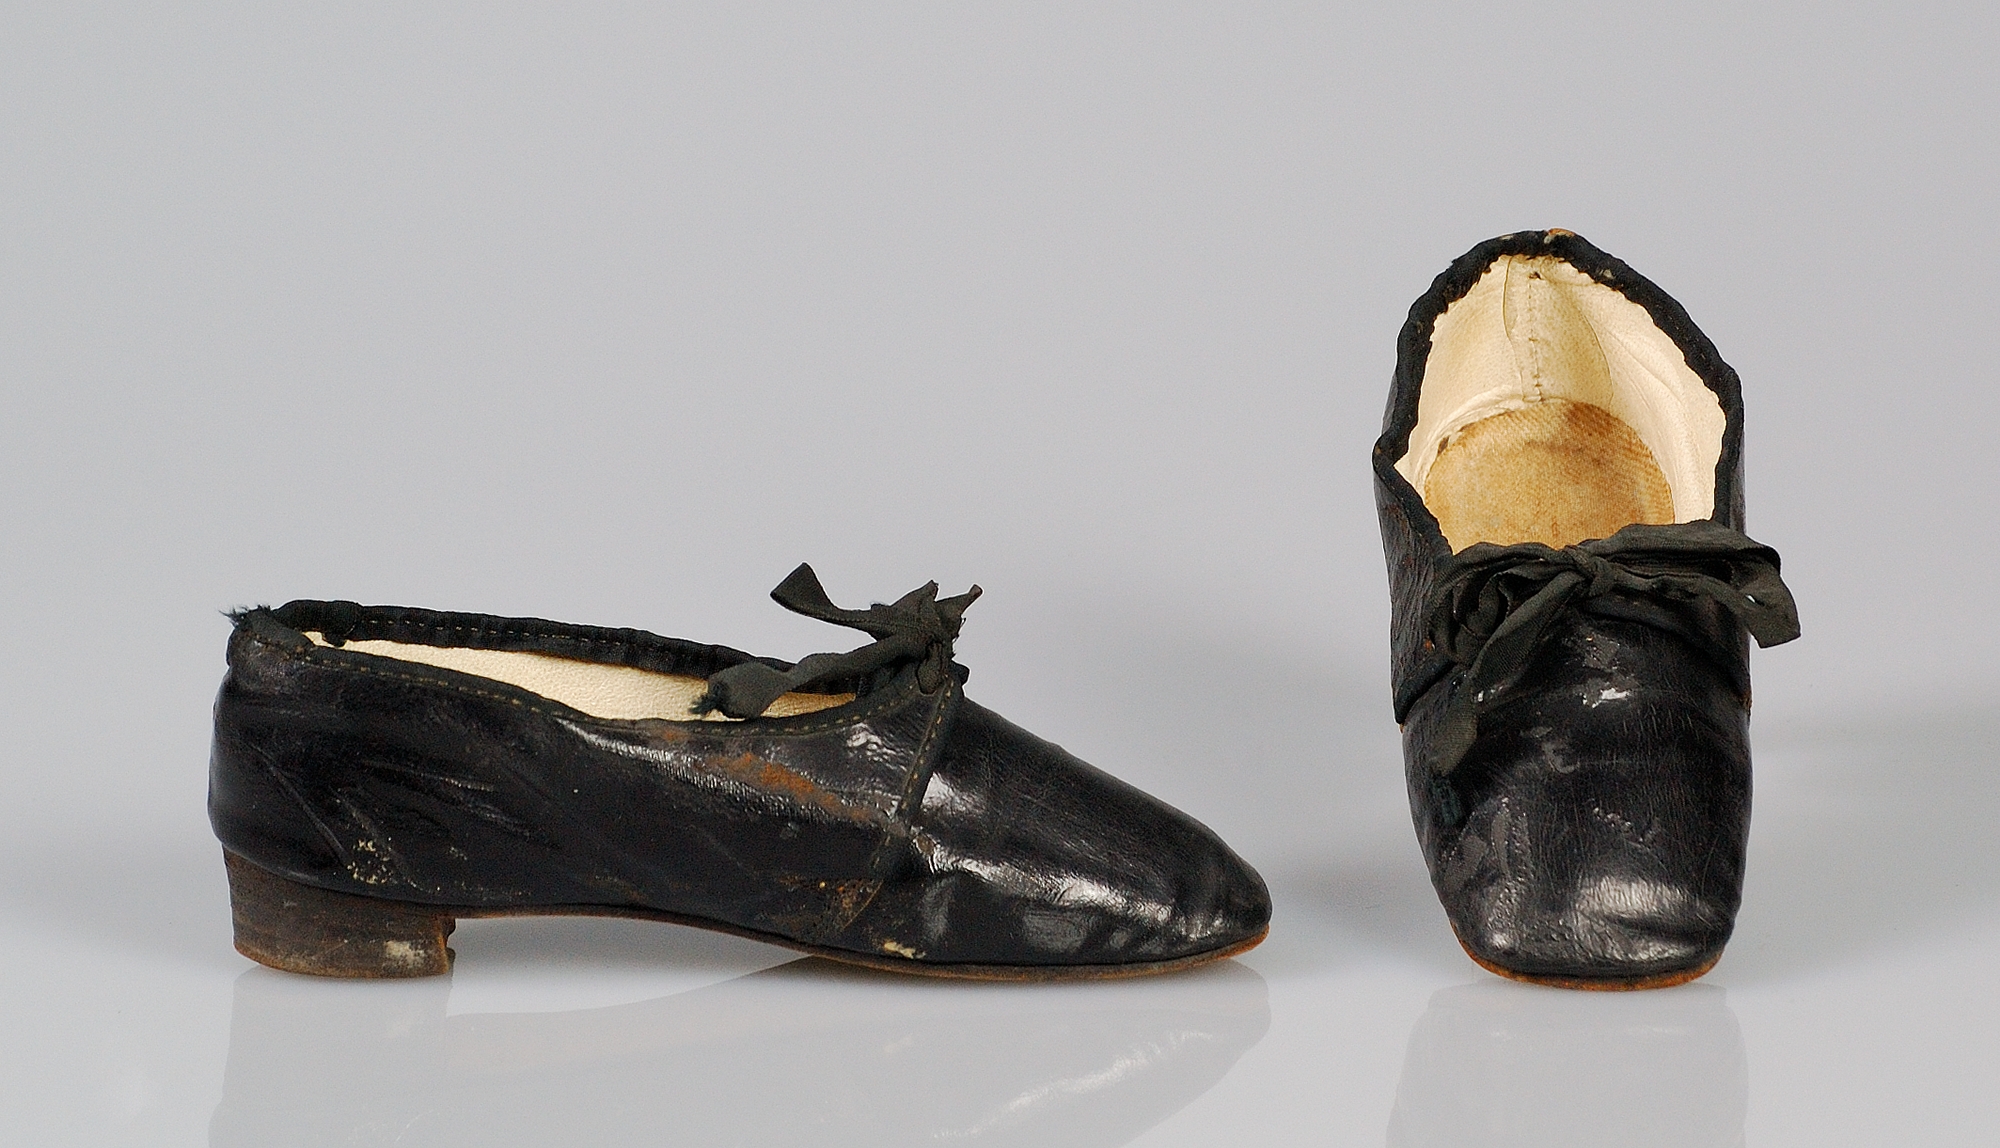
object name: shoe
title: Shoes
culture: american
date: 1840-1859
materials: leather